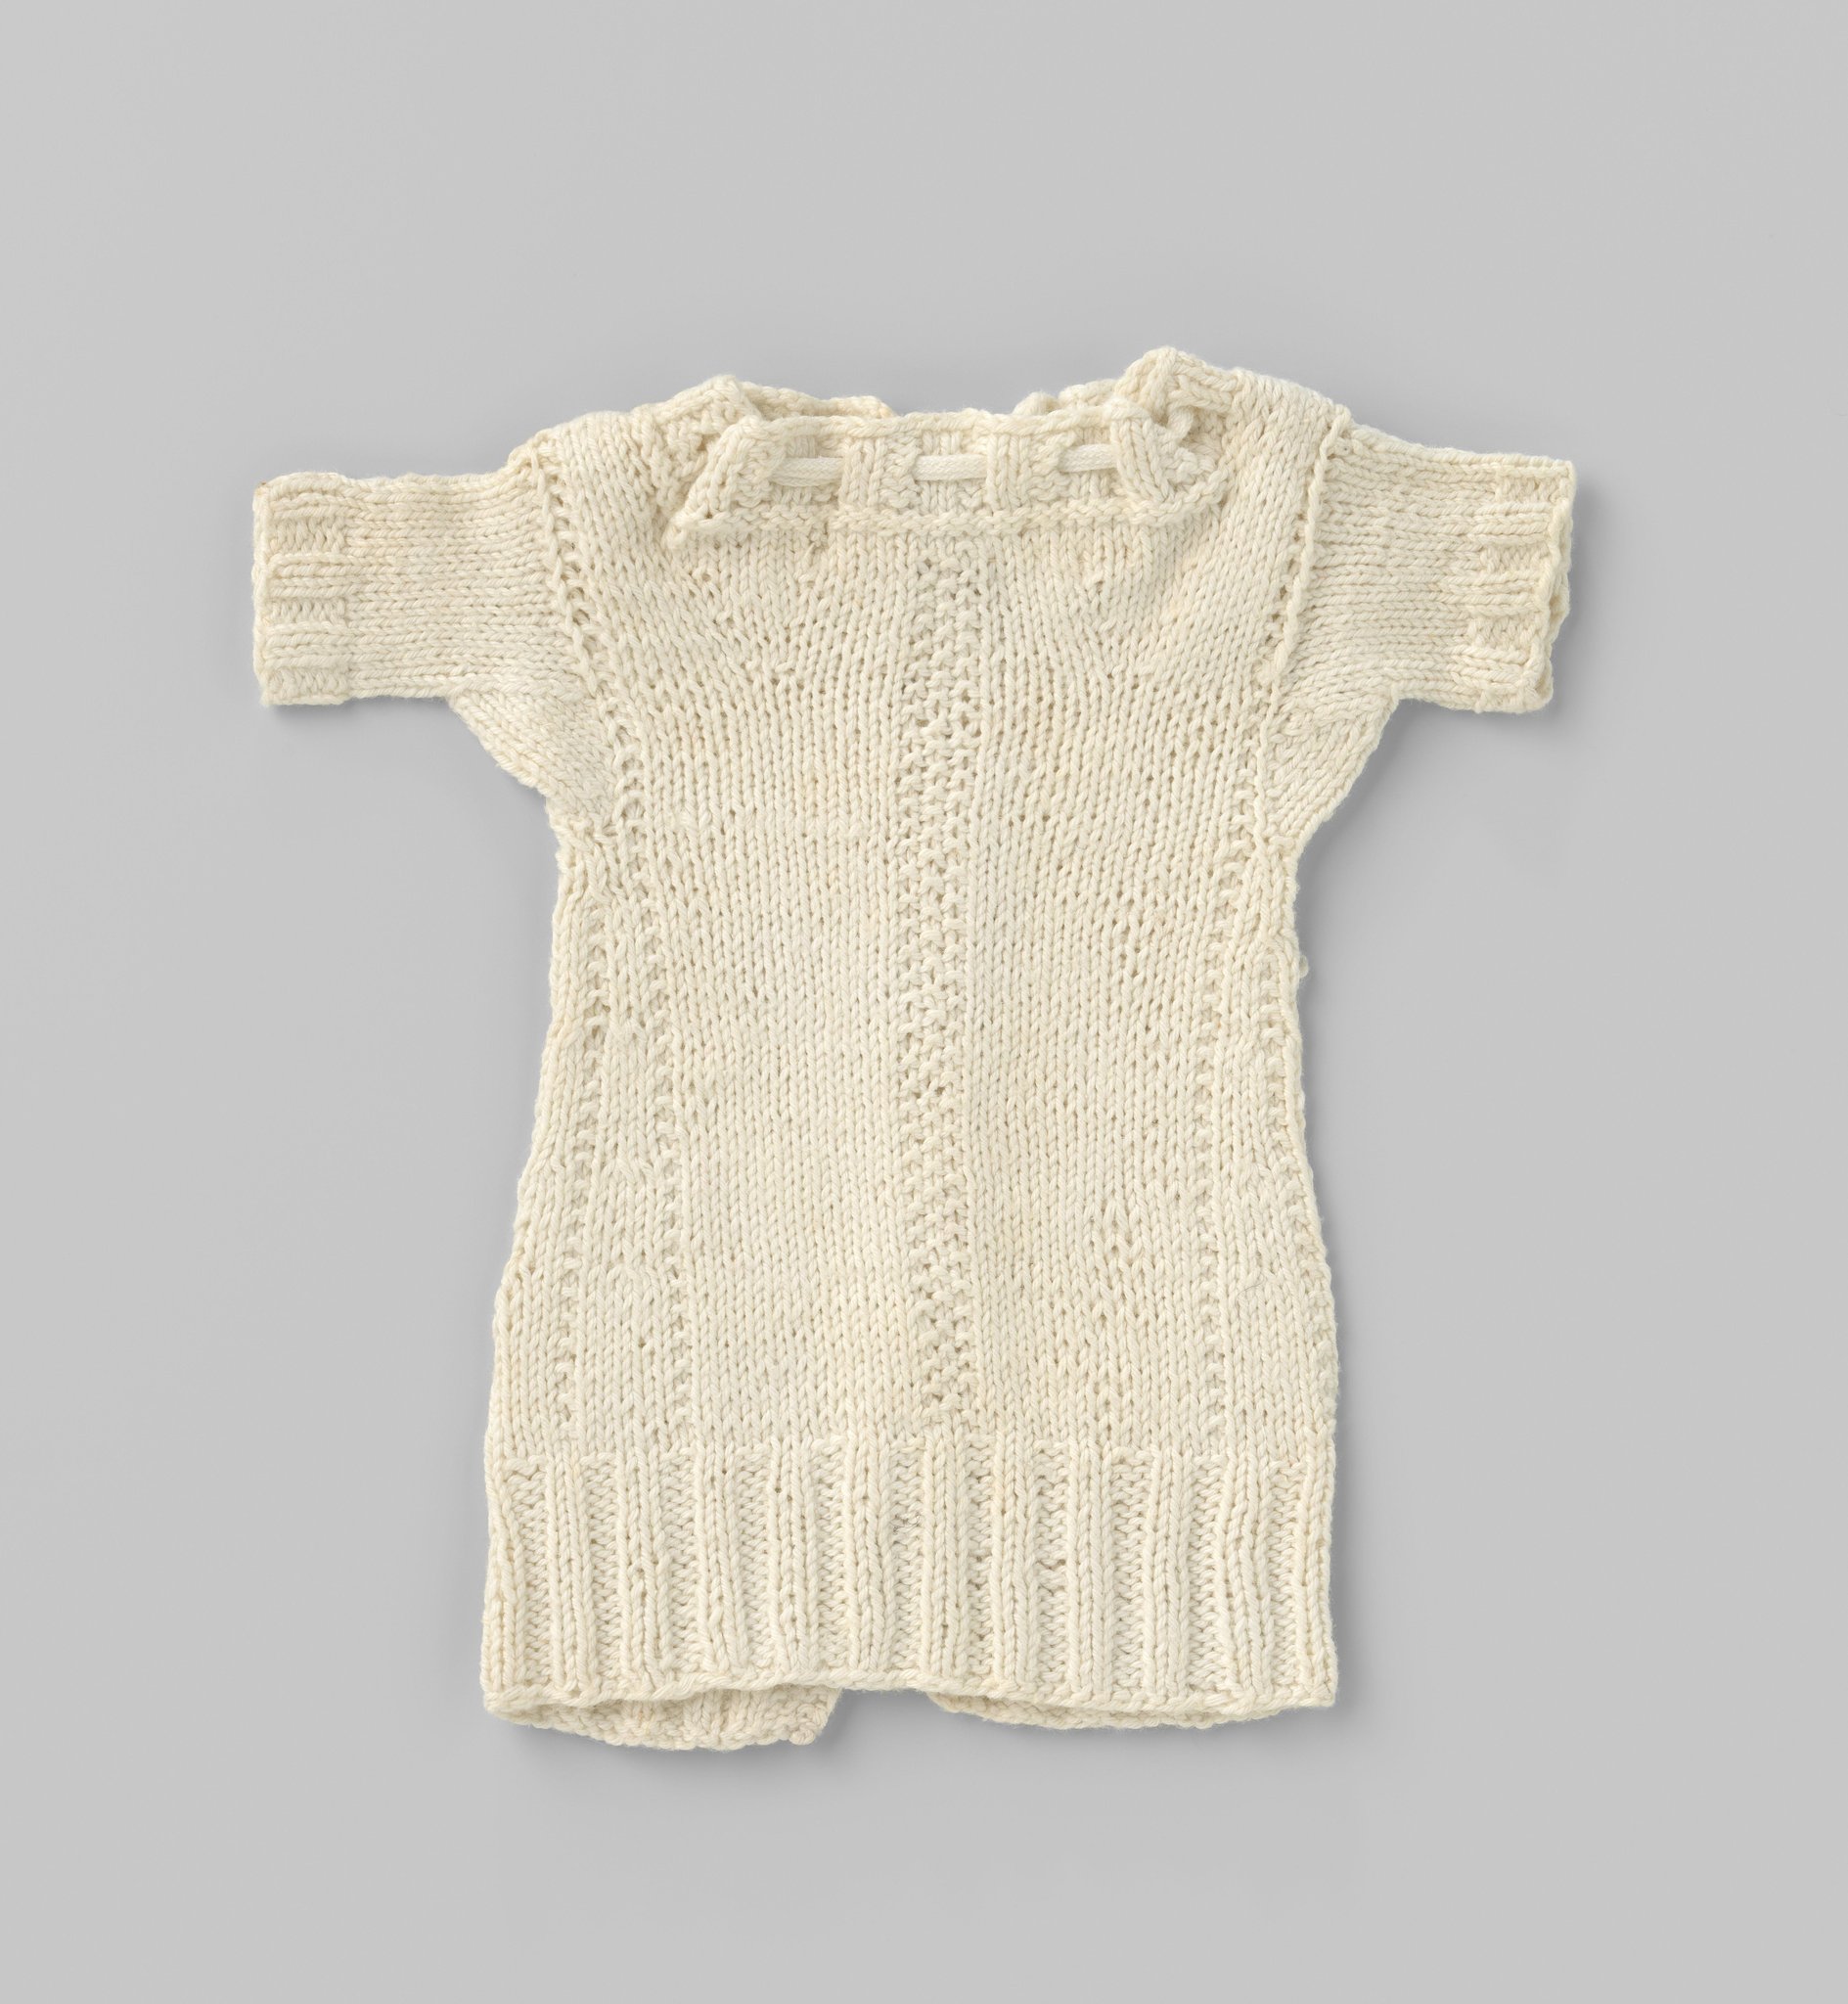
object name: toy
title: Hemd van wit gebreid katoen voor pop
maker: Anonymous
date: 1850-1920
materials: cotton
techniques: knitting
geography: netherlands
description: Rond de hals een lint en aan de achterzijde een rijgveter.